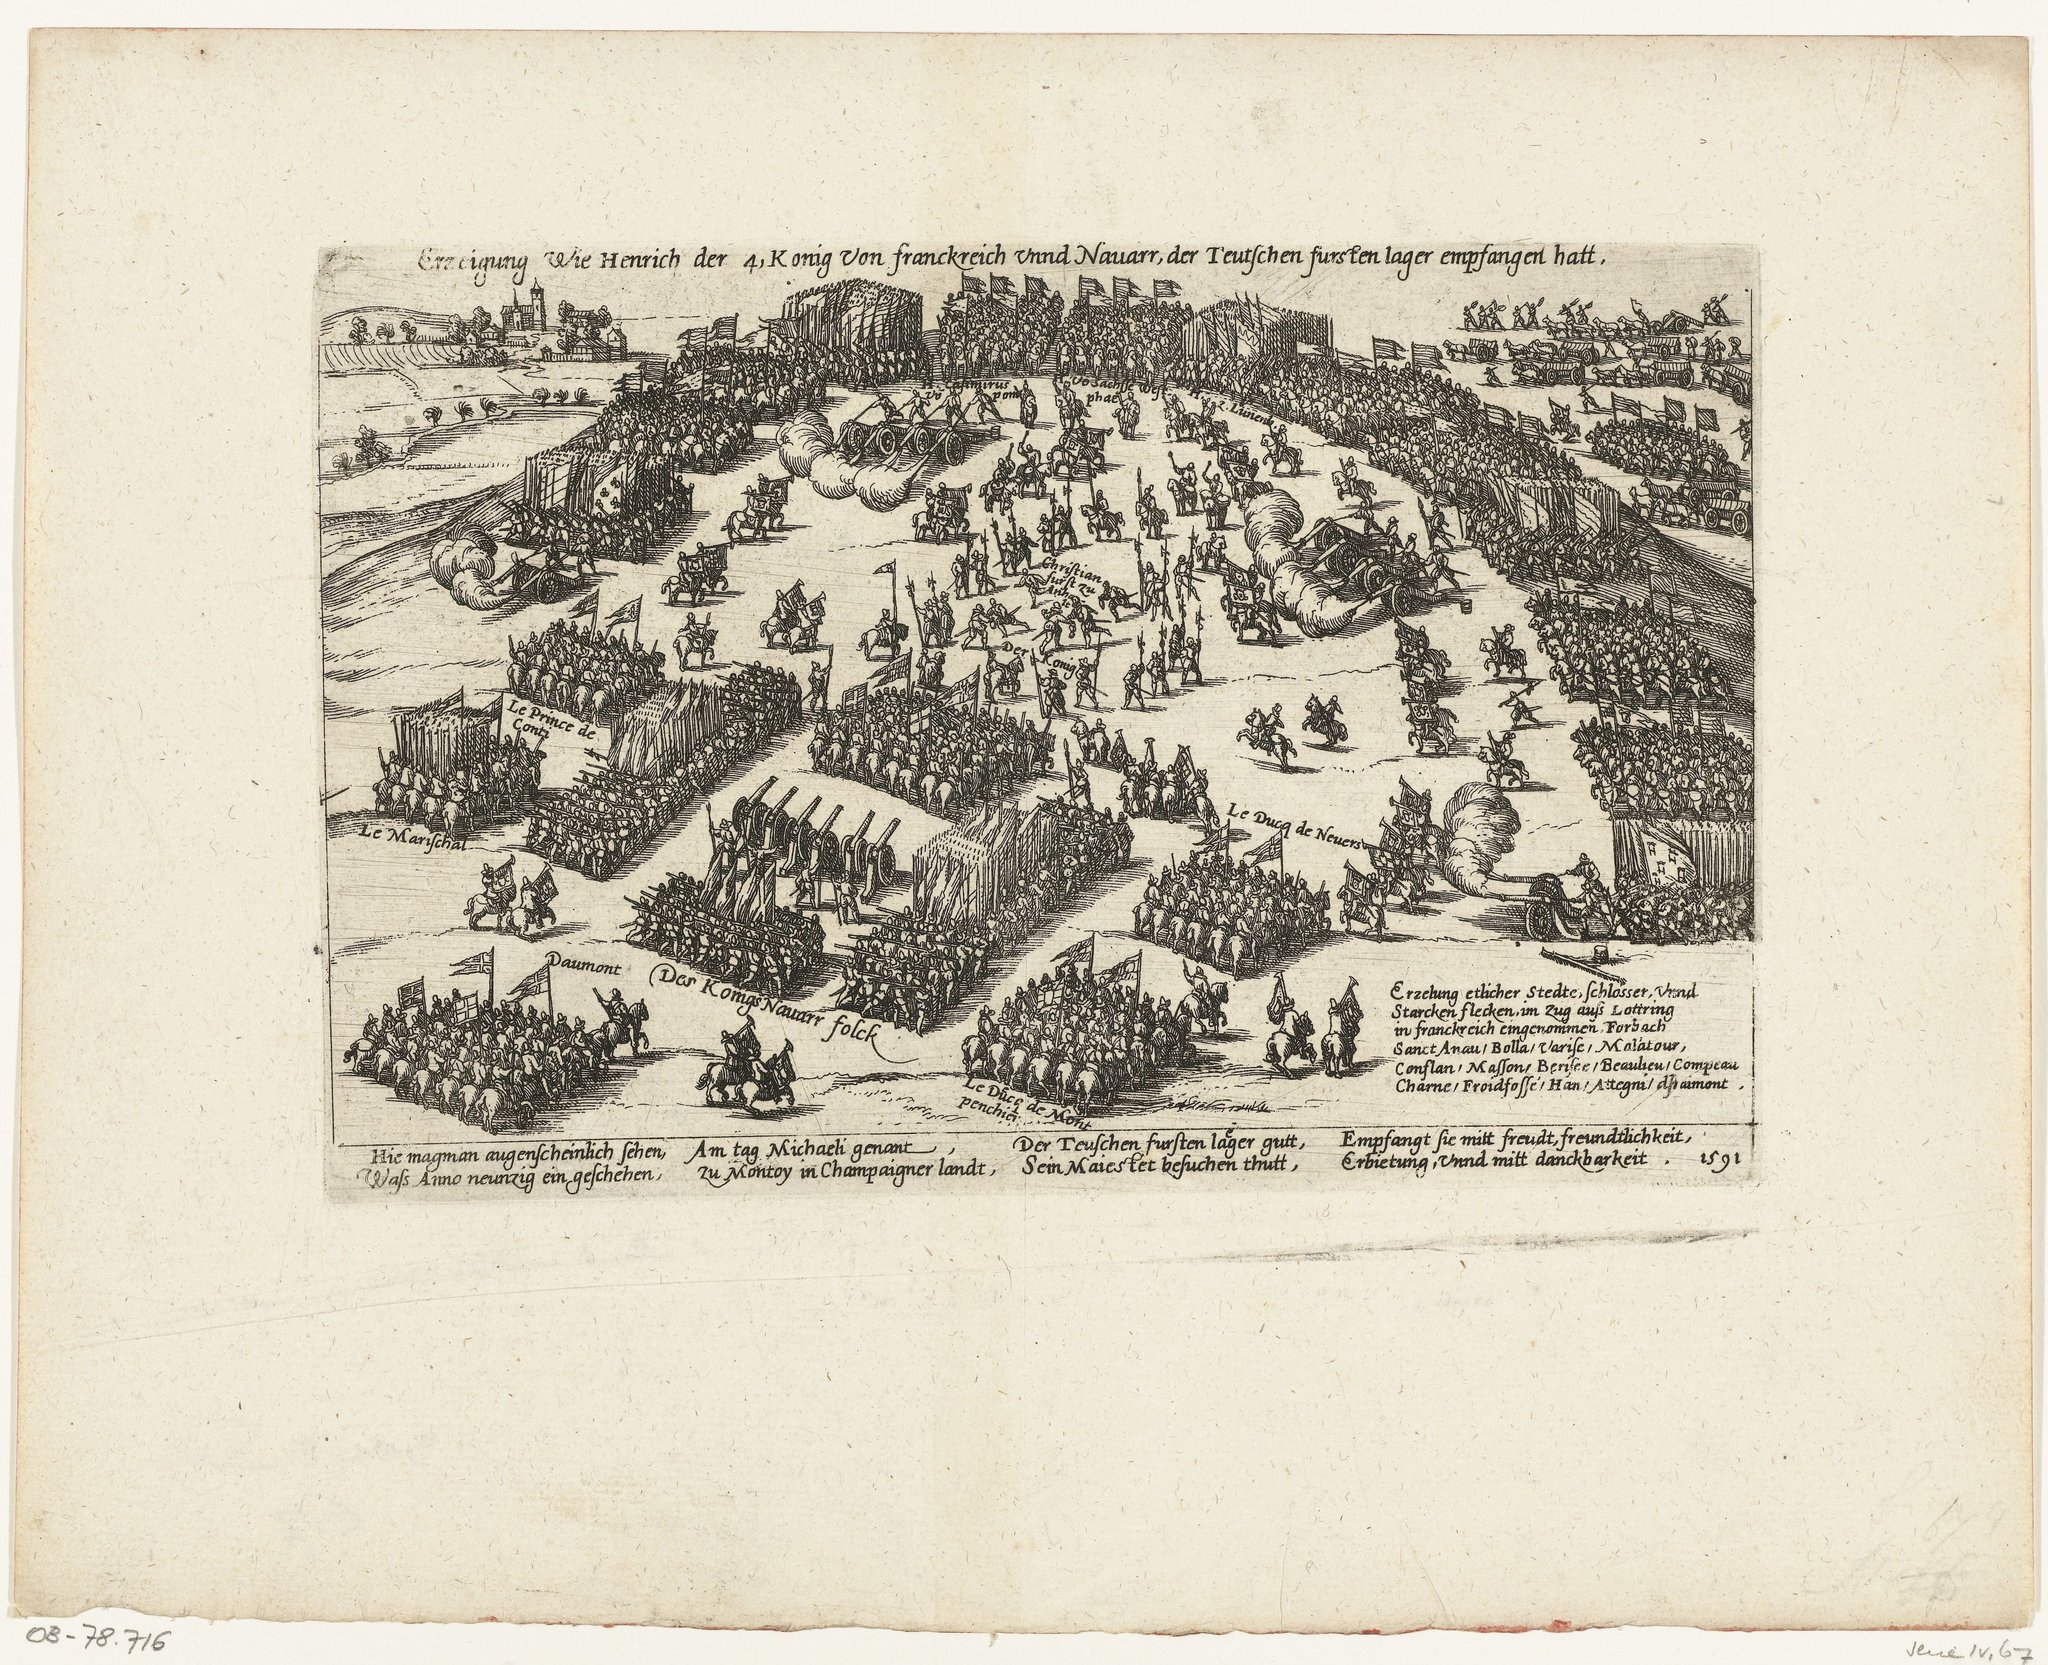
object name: print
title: Serie 4: Franse, Duitse en Engelse Gebeurtenissen, 1576-1610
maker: frans hogenberg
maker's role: print maker, publisher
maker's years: 1538-1590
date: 1591-1593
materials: paper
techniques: etching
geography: cologne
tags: paris, hendrik iv (koning van frankrijk en navarra)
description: Ontvangst van Hendrik IV en zijn troepen bij het Duitse leger, 1591. Met onderschrift van 8 regels in het Duits. Ongenummerd. Papier met rode randjes.